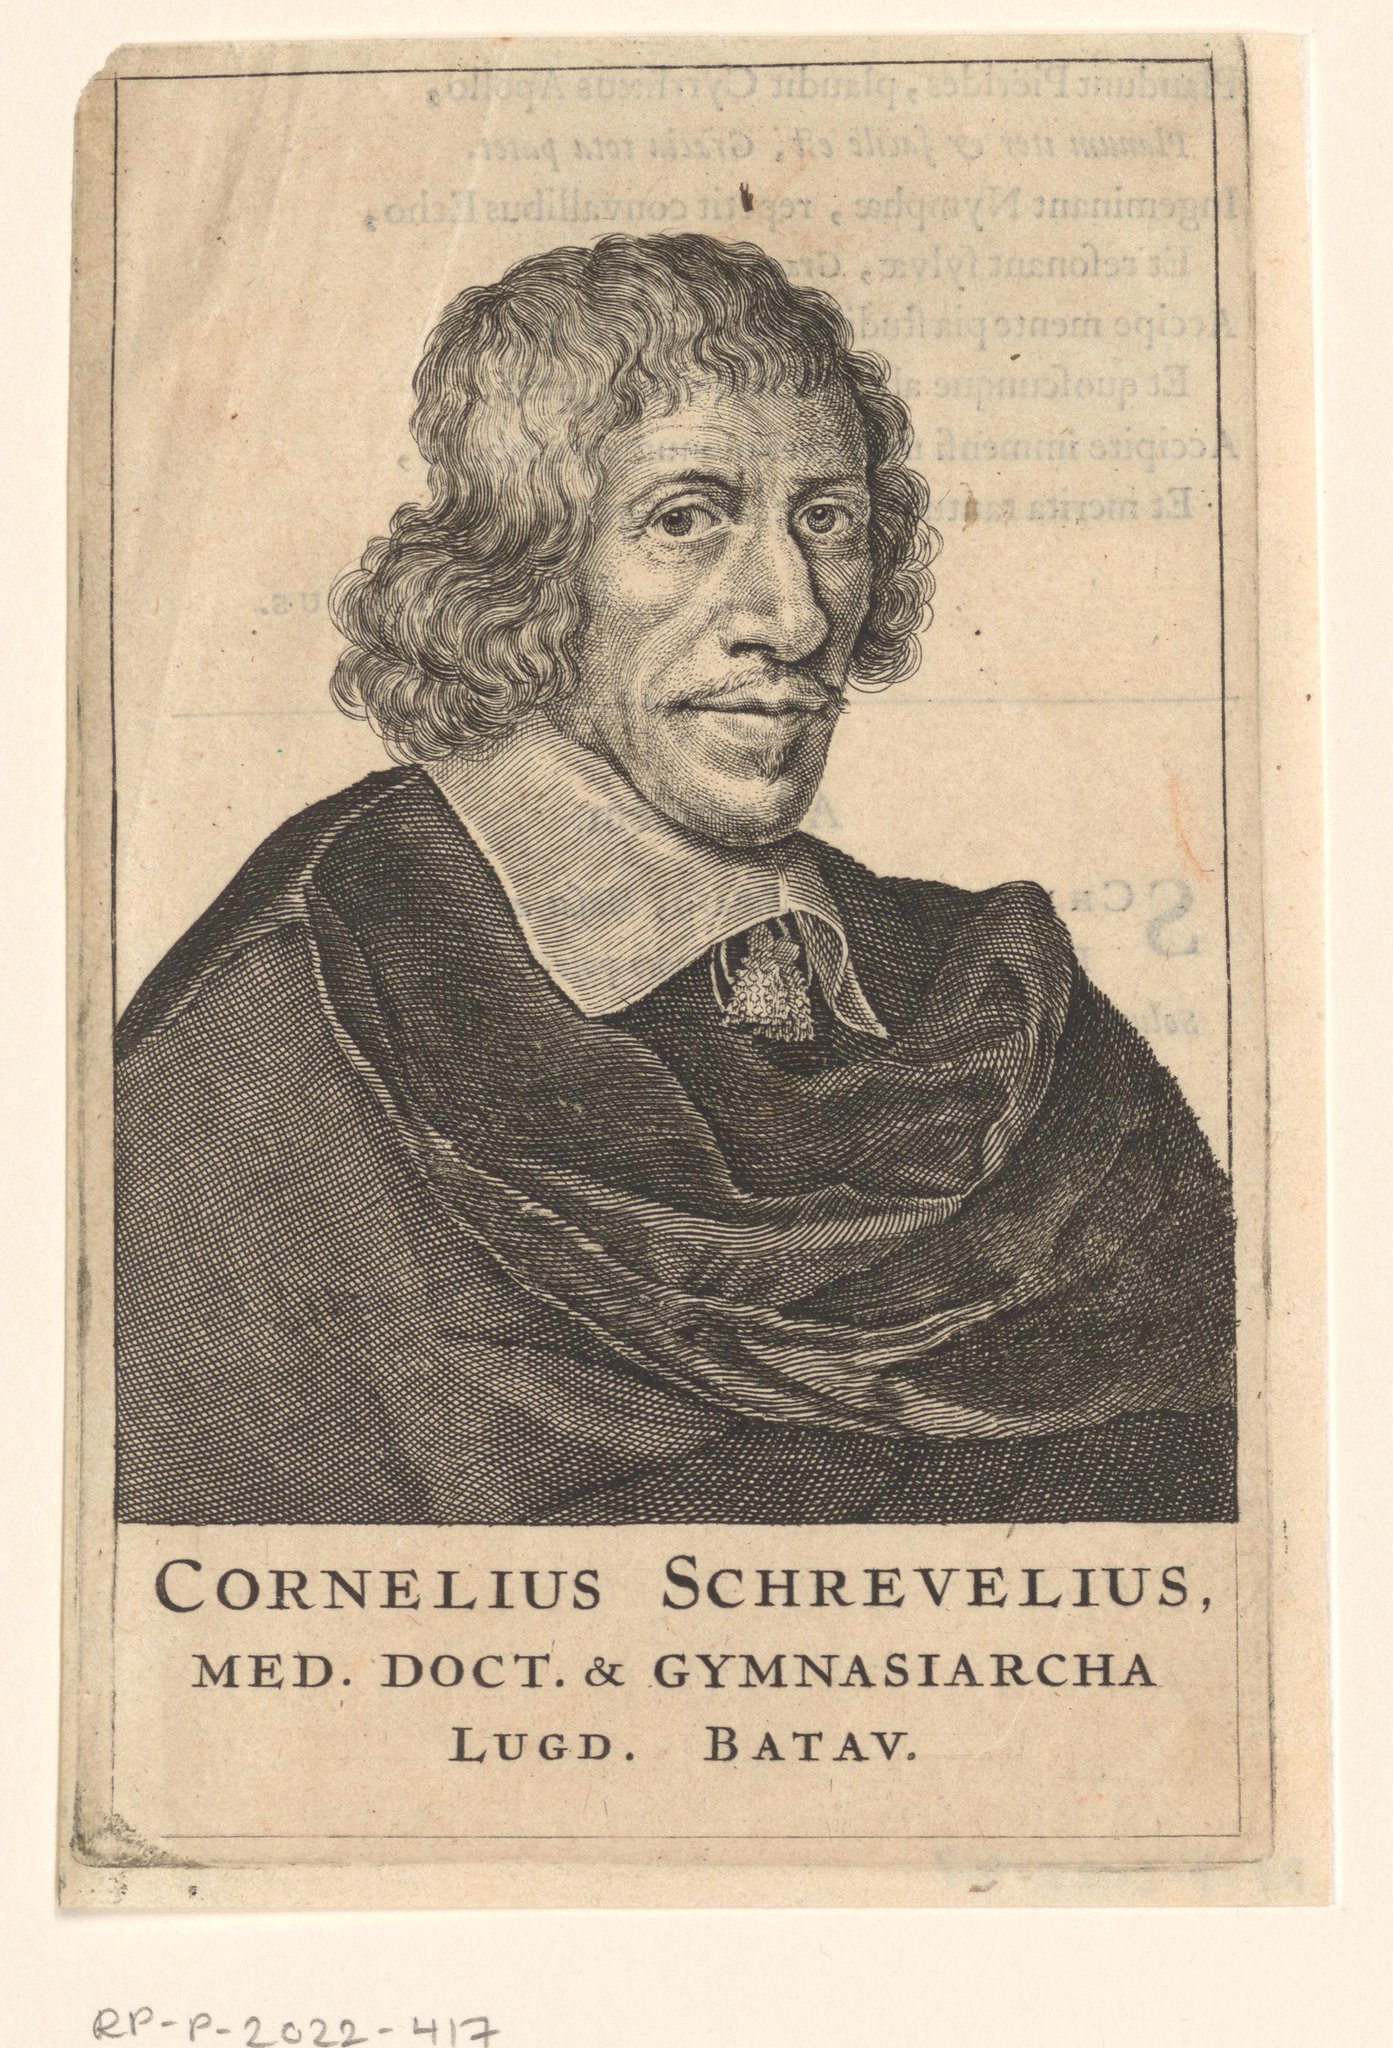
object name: book illustration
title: Portret van Cornelius Schrevelius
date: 1661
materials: paper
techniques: engraving, letterpress printing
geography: leiden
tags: historical persons, physician, doctor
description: Prent uit: Schrevelius, Cornelius. Lexicon manual Graeco-Latinum & Latino-Graecum. 3e editie. Leiden: Franciscus Hackius, 1661.